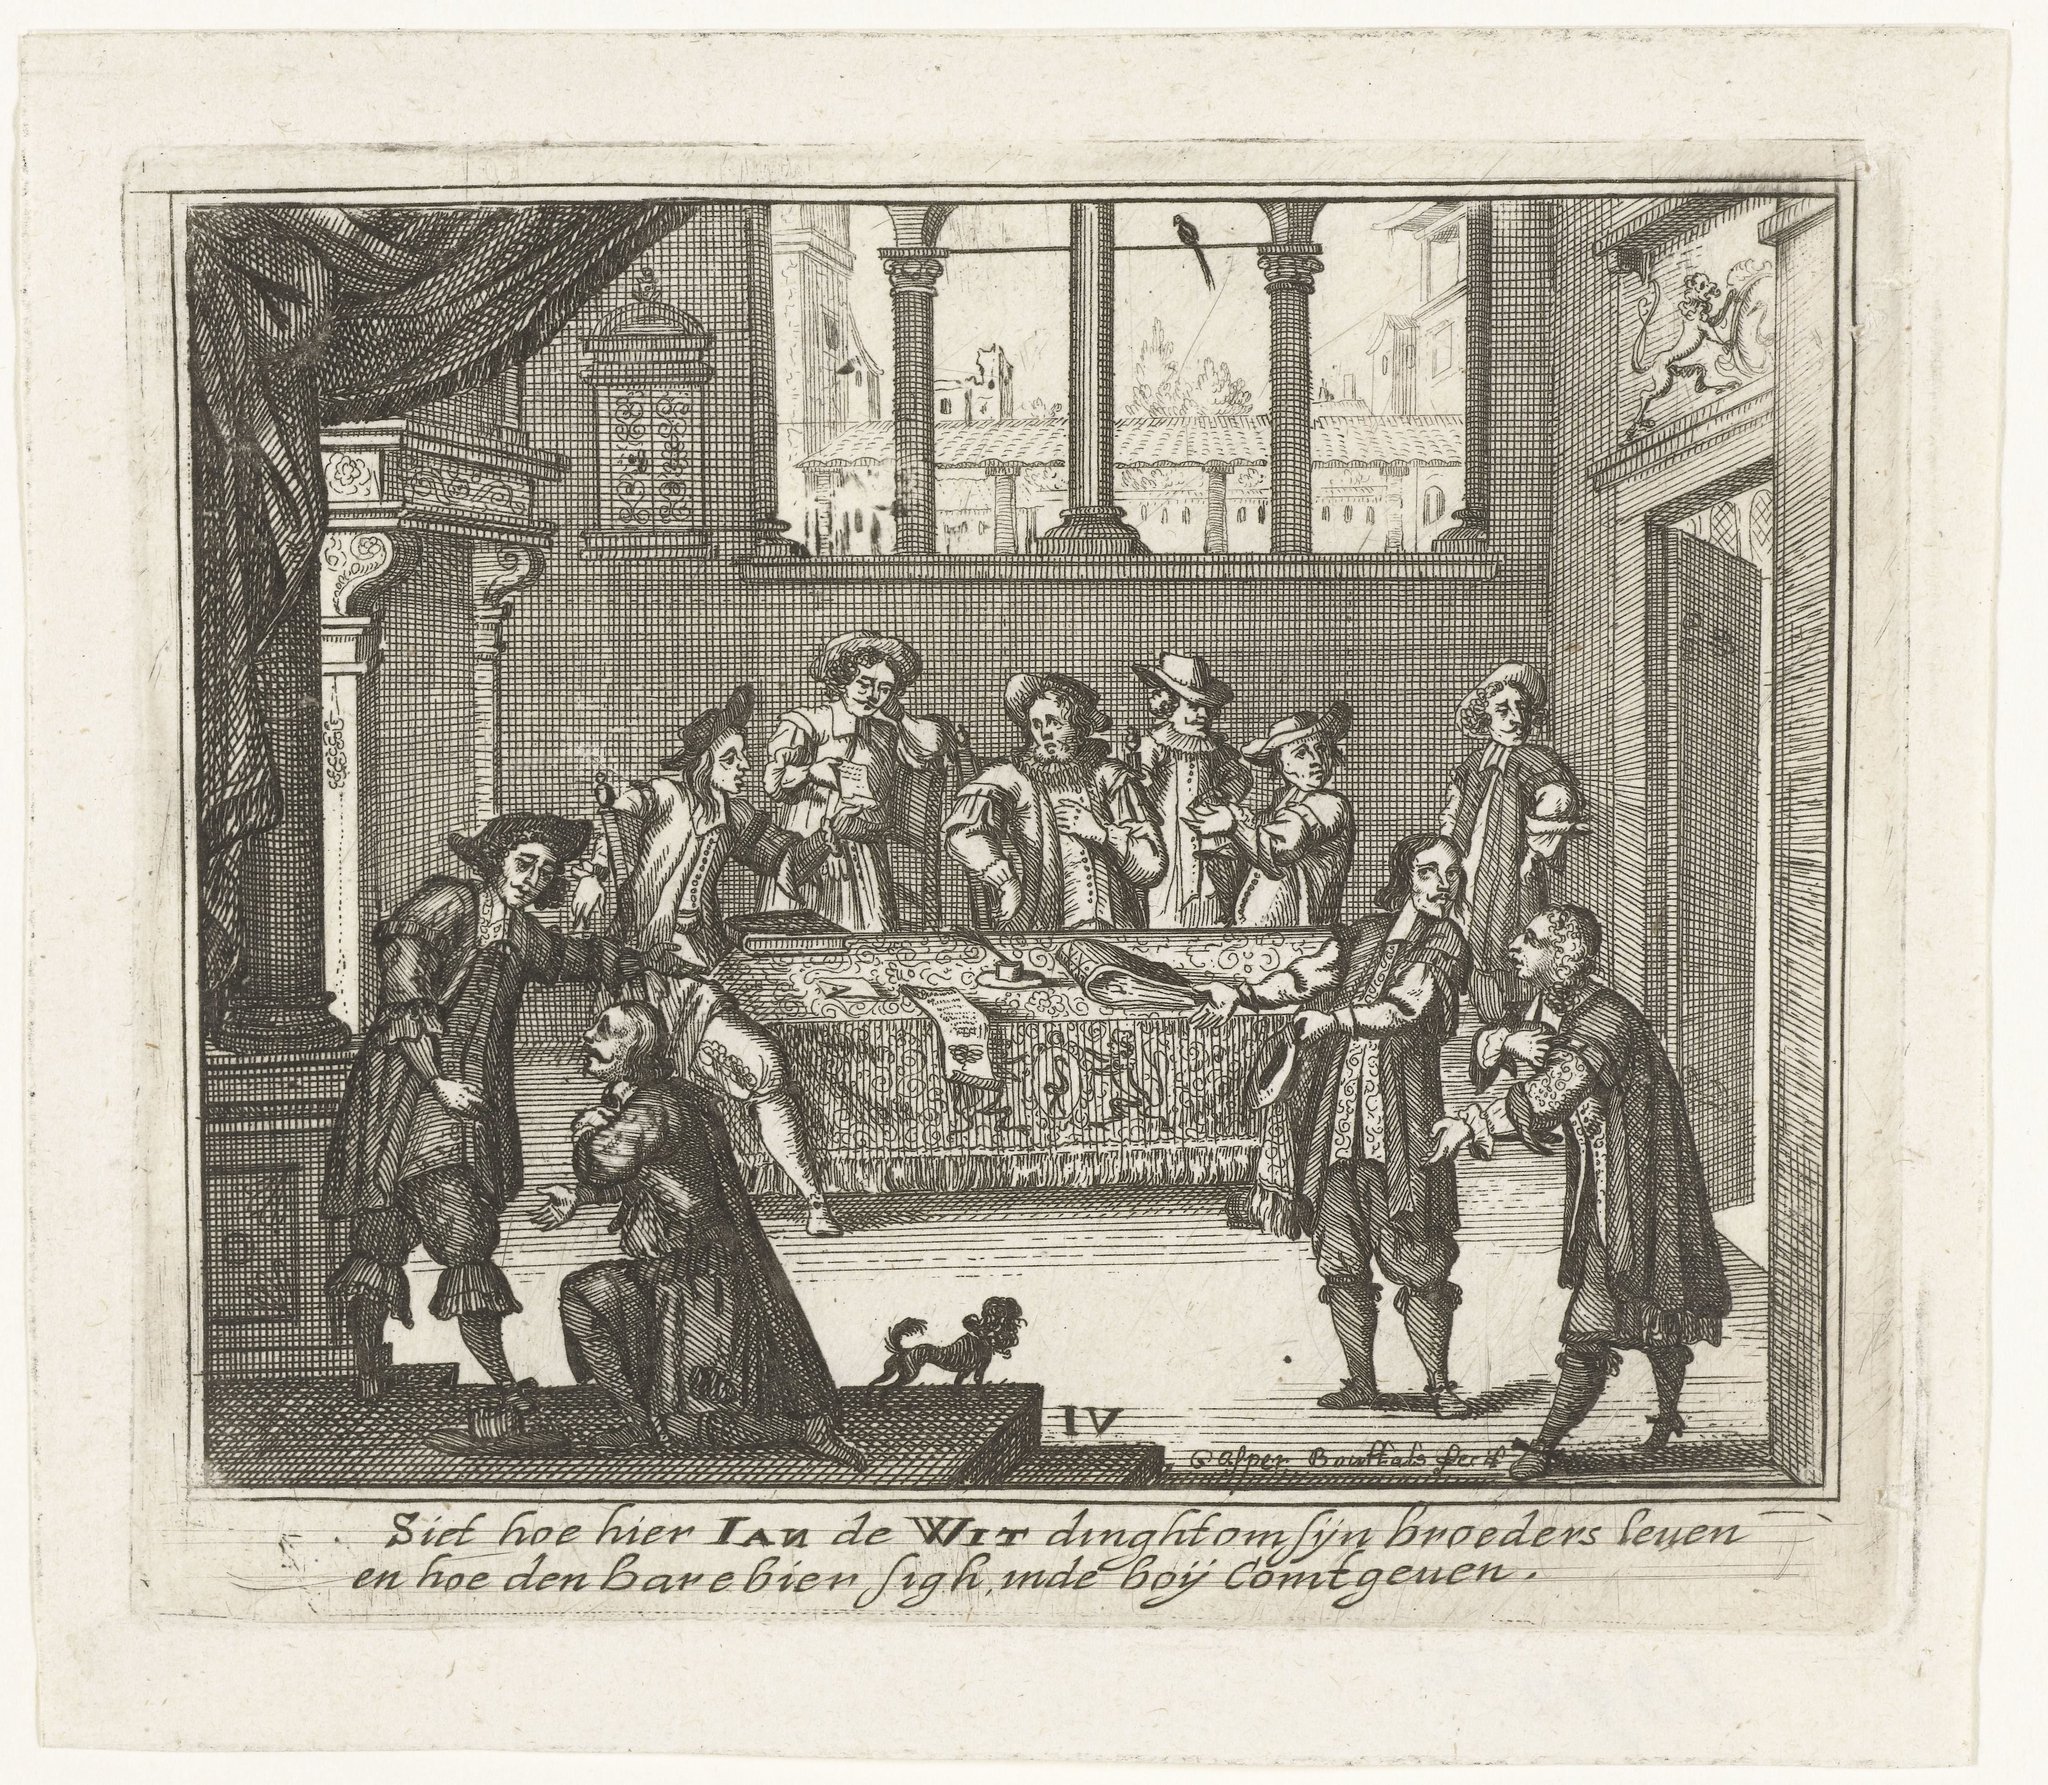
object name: print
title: Acht voorstellingen uit het leven van de gebroeders De Witt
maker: gaspar bouttats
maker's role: print maker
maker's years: 1640-1695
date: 1672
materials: paper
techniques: etching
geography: antwerp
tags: dordrecht, the hague, cornelis de witt, politician, johan de witt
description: Vierde prent in een reeks van acht voorstellingen over het leven van Johan en Cornelis de Witt. Alle prenten zijn van de hand van Gaspar Bouttats en hebben een vers van vier of twee regels. In de voorstelling is te zien hoe Johan de Witt pleit voor de vrijlating van zijn broer, 1672.